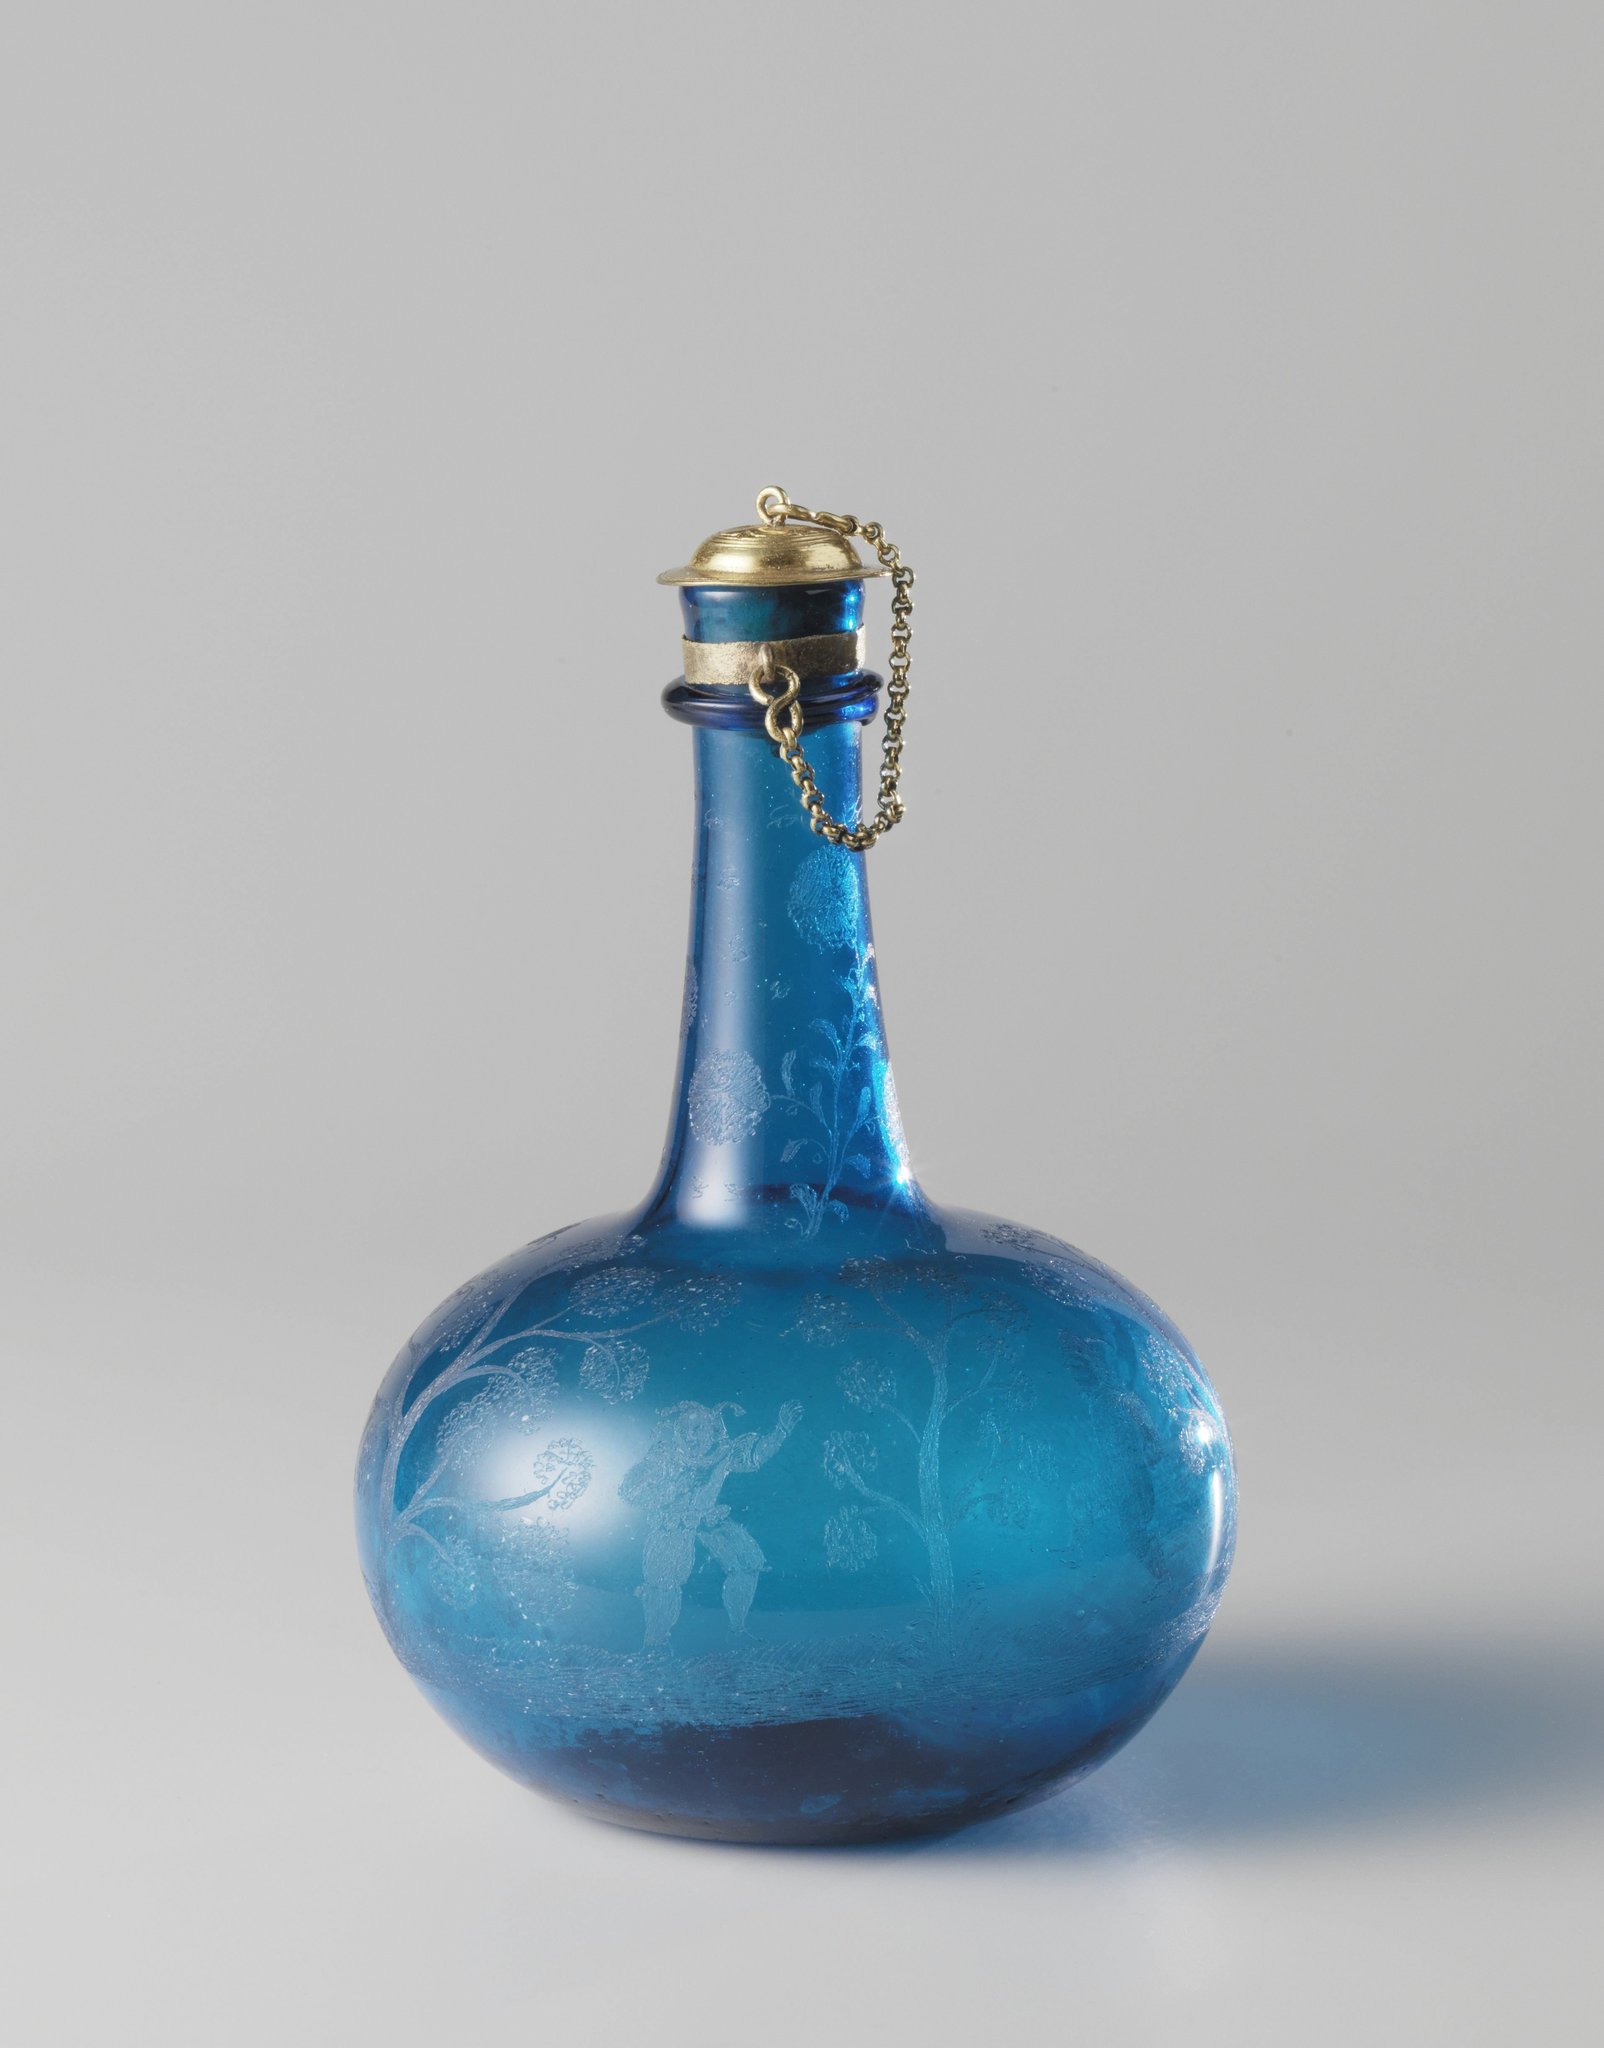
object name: sierfles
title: Fles met figuren in een landschap met bomen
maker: Anonymous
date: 1650-1700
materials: copper, glass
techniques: diamond point engraving, gilding, glassblowing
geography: low countries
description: Fles van blauwe glas. Ingestoken ziel met pontilmerk. Bolvormig lichaam, lange slanke hals met opgelegde ring rond de nek. Boven de ring een verguld koperen montuur met een ketting, waaraan een in verguld koper gemonteerde kurk is bevestigd. Op het lichaam zijn tussen bomen een nar, een dansende man en een heer die een buiging maakt voor een mandoliene spelende dame gegraveerd. Op de hals twee bloemranken.